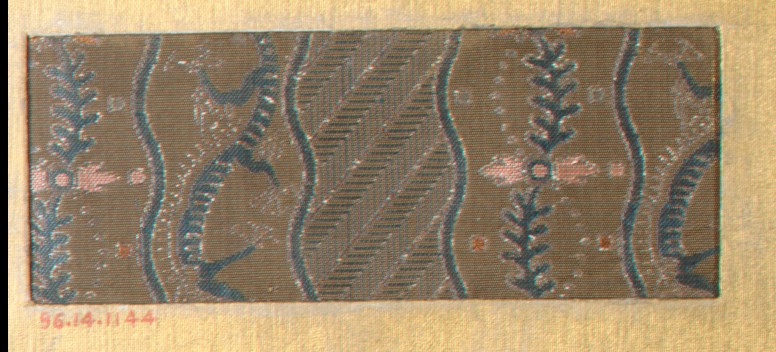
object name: piece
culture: japanese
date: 1701-1900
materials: silk